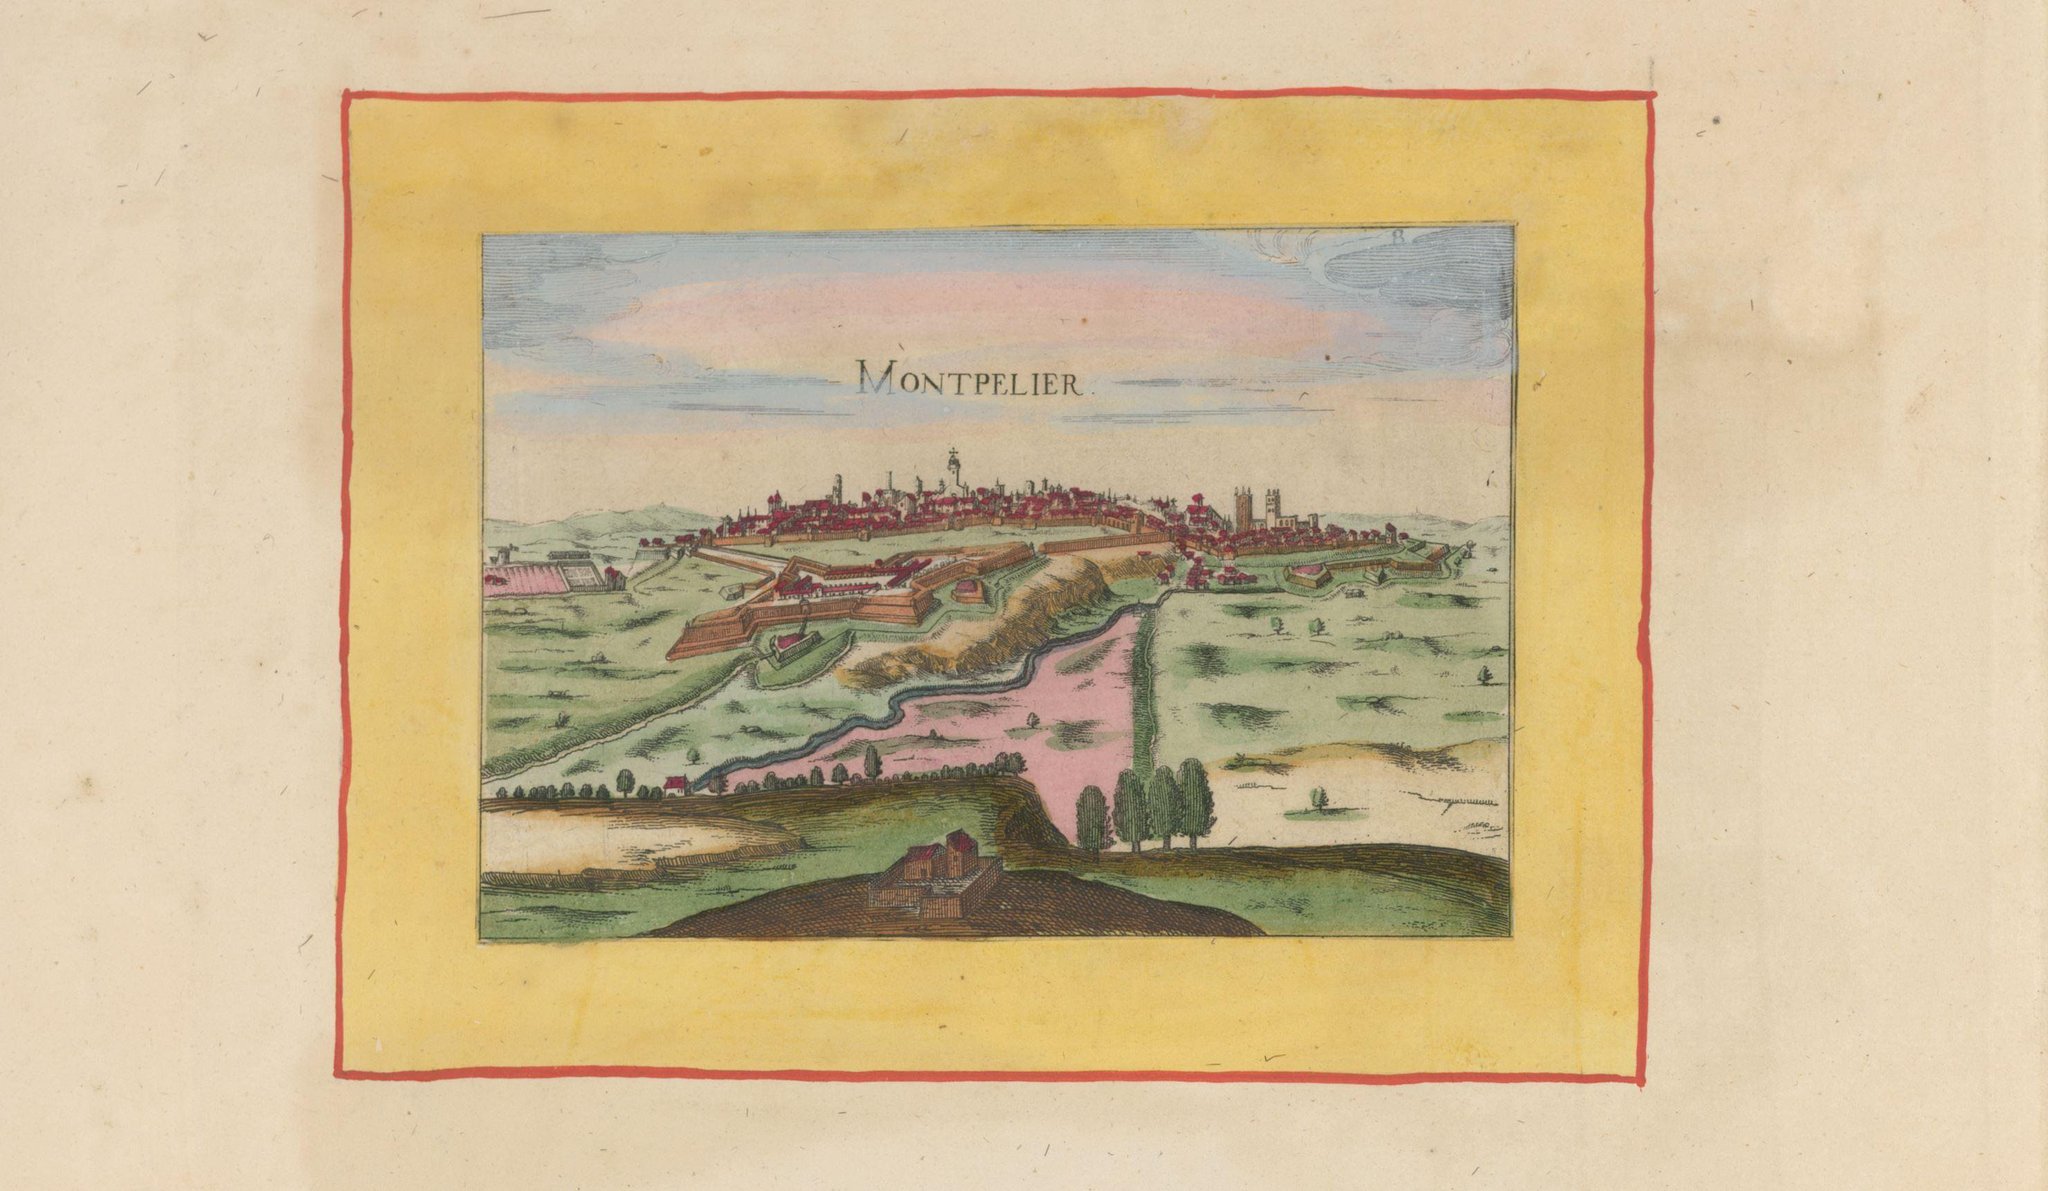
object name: album leaf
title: Montpelier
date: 1638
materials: paper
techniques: engraving, etching, hand coloring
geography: the hague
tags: city-view in general; 'veduta'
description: Prent uit: Tassin, Christophe. Les plans et profils de toutes les principales villes et lieux considérables de France (...). Parijs: Michel van Lochom, 1638, prent nummer 8 in het deel 'Languedoc'.